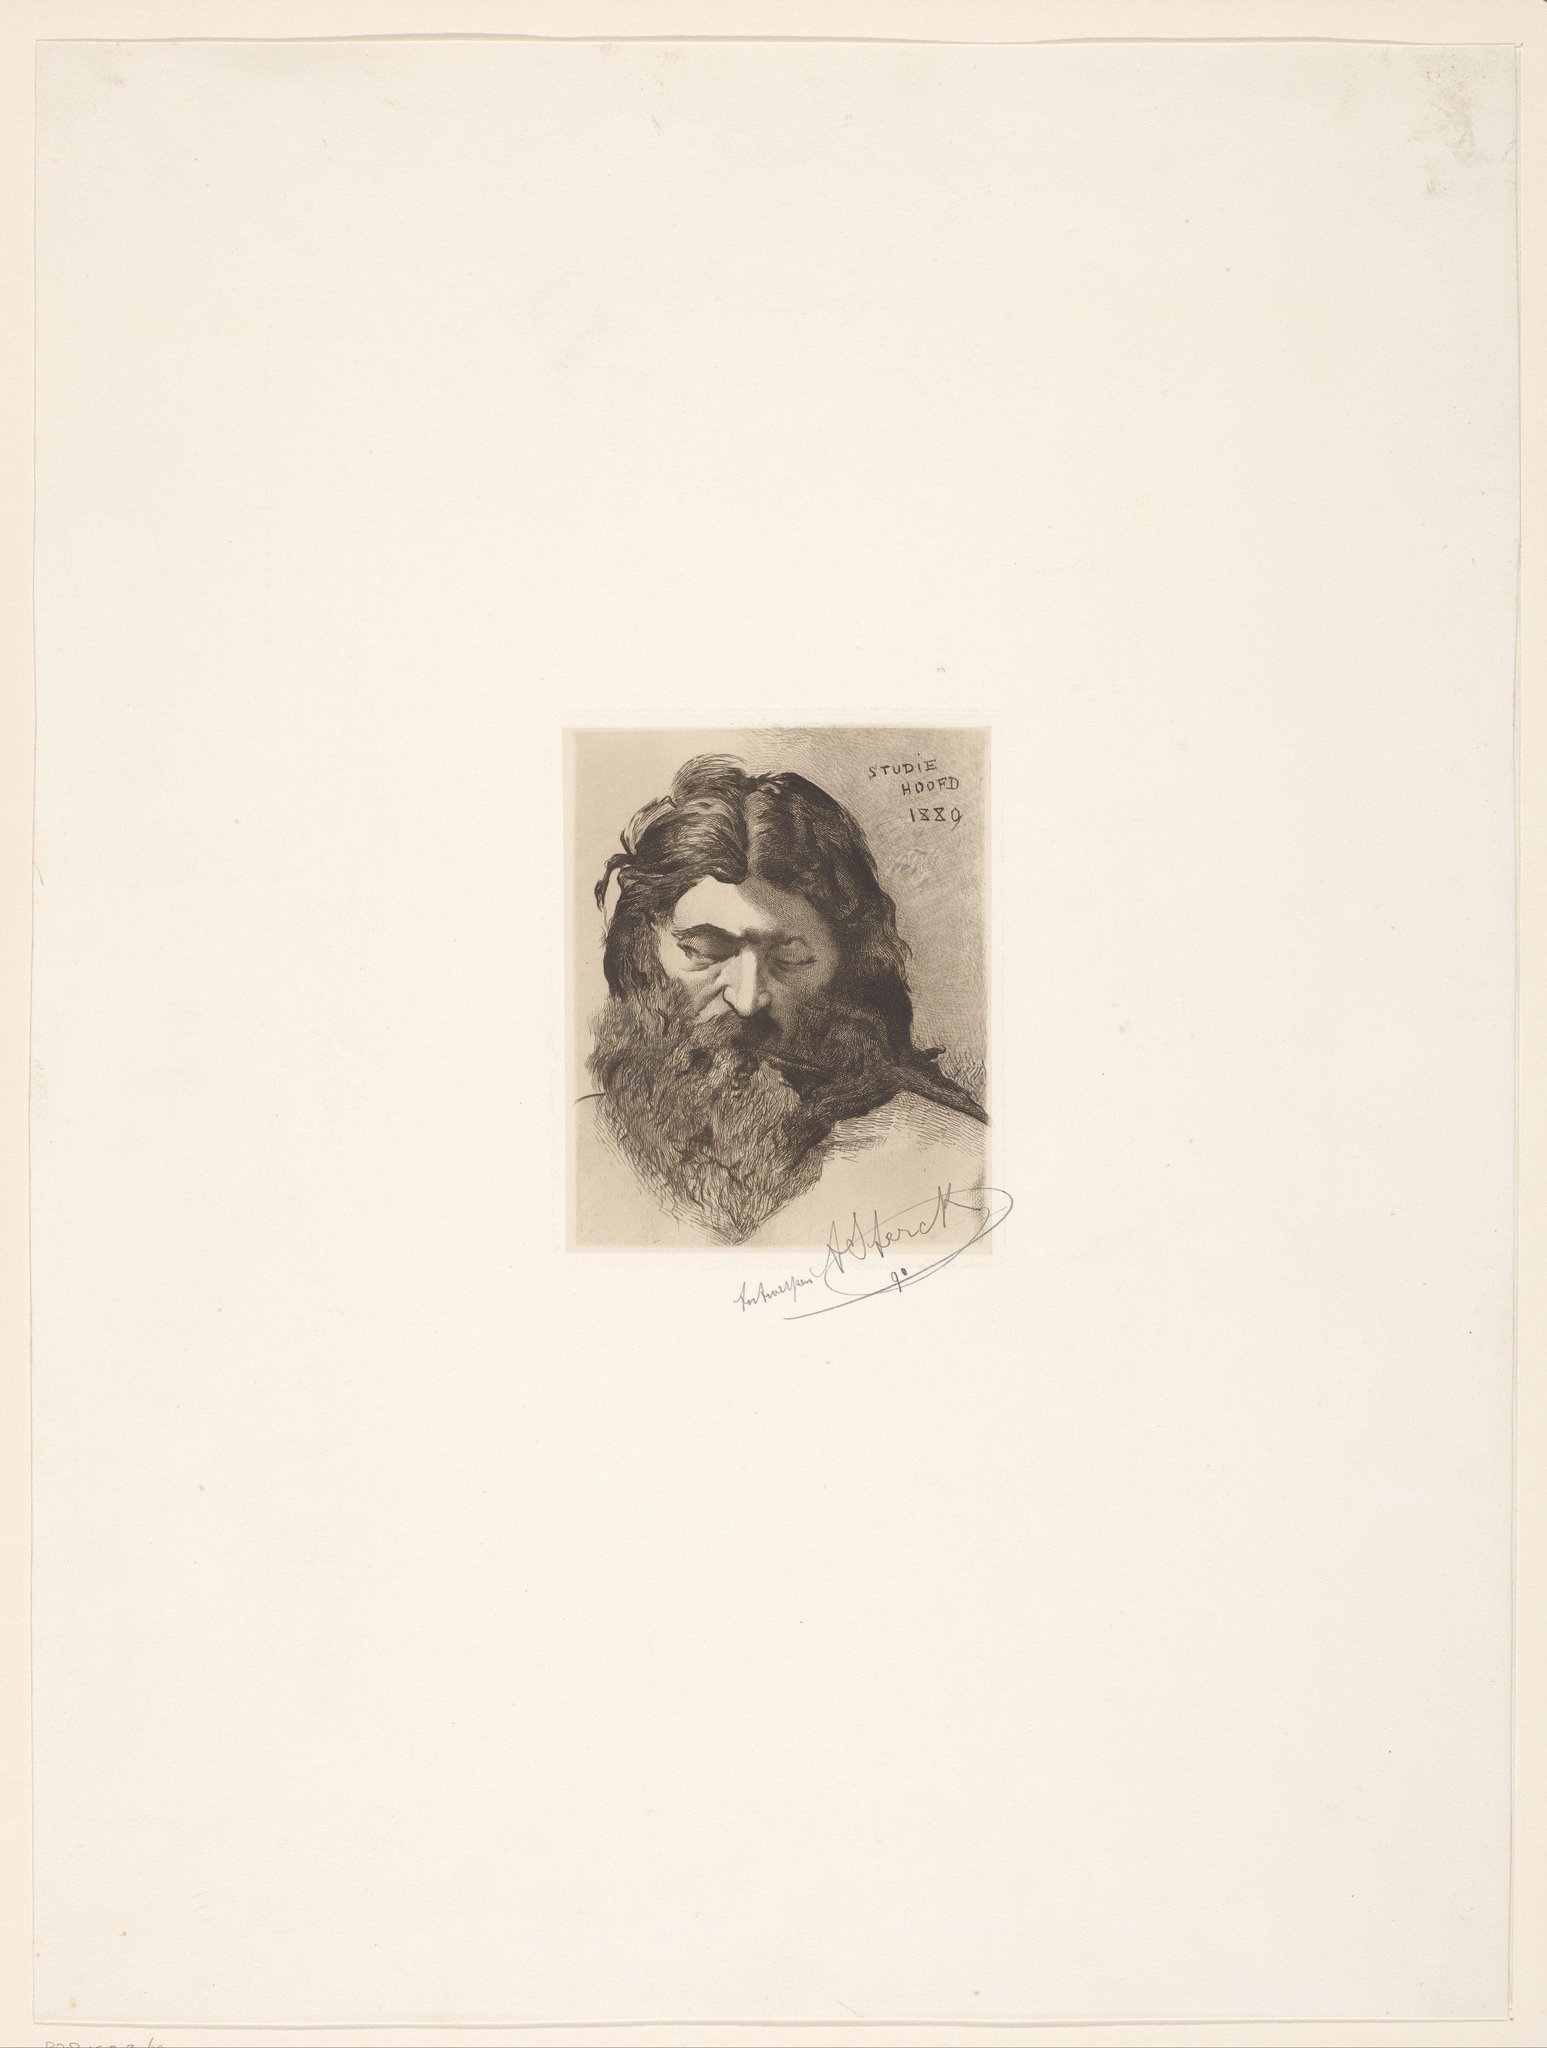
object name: print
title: Portret van een onbekende man met een baard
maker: arthur sterck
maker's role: print maker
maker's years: 1868-1897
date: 1890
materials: paper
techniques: drypoint, etching, retroussage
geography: antwerp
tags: anonymous historical person portrayed alone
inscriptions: collector's mark: Lugt 2228